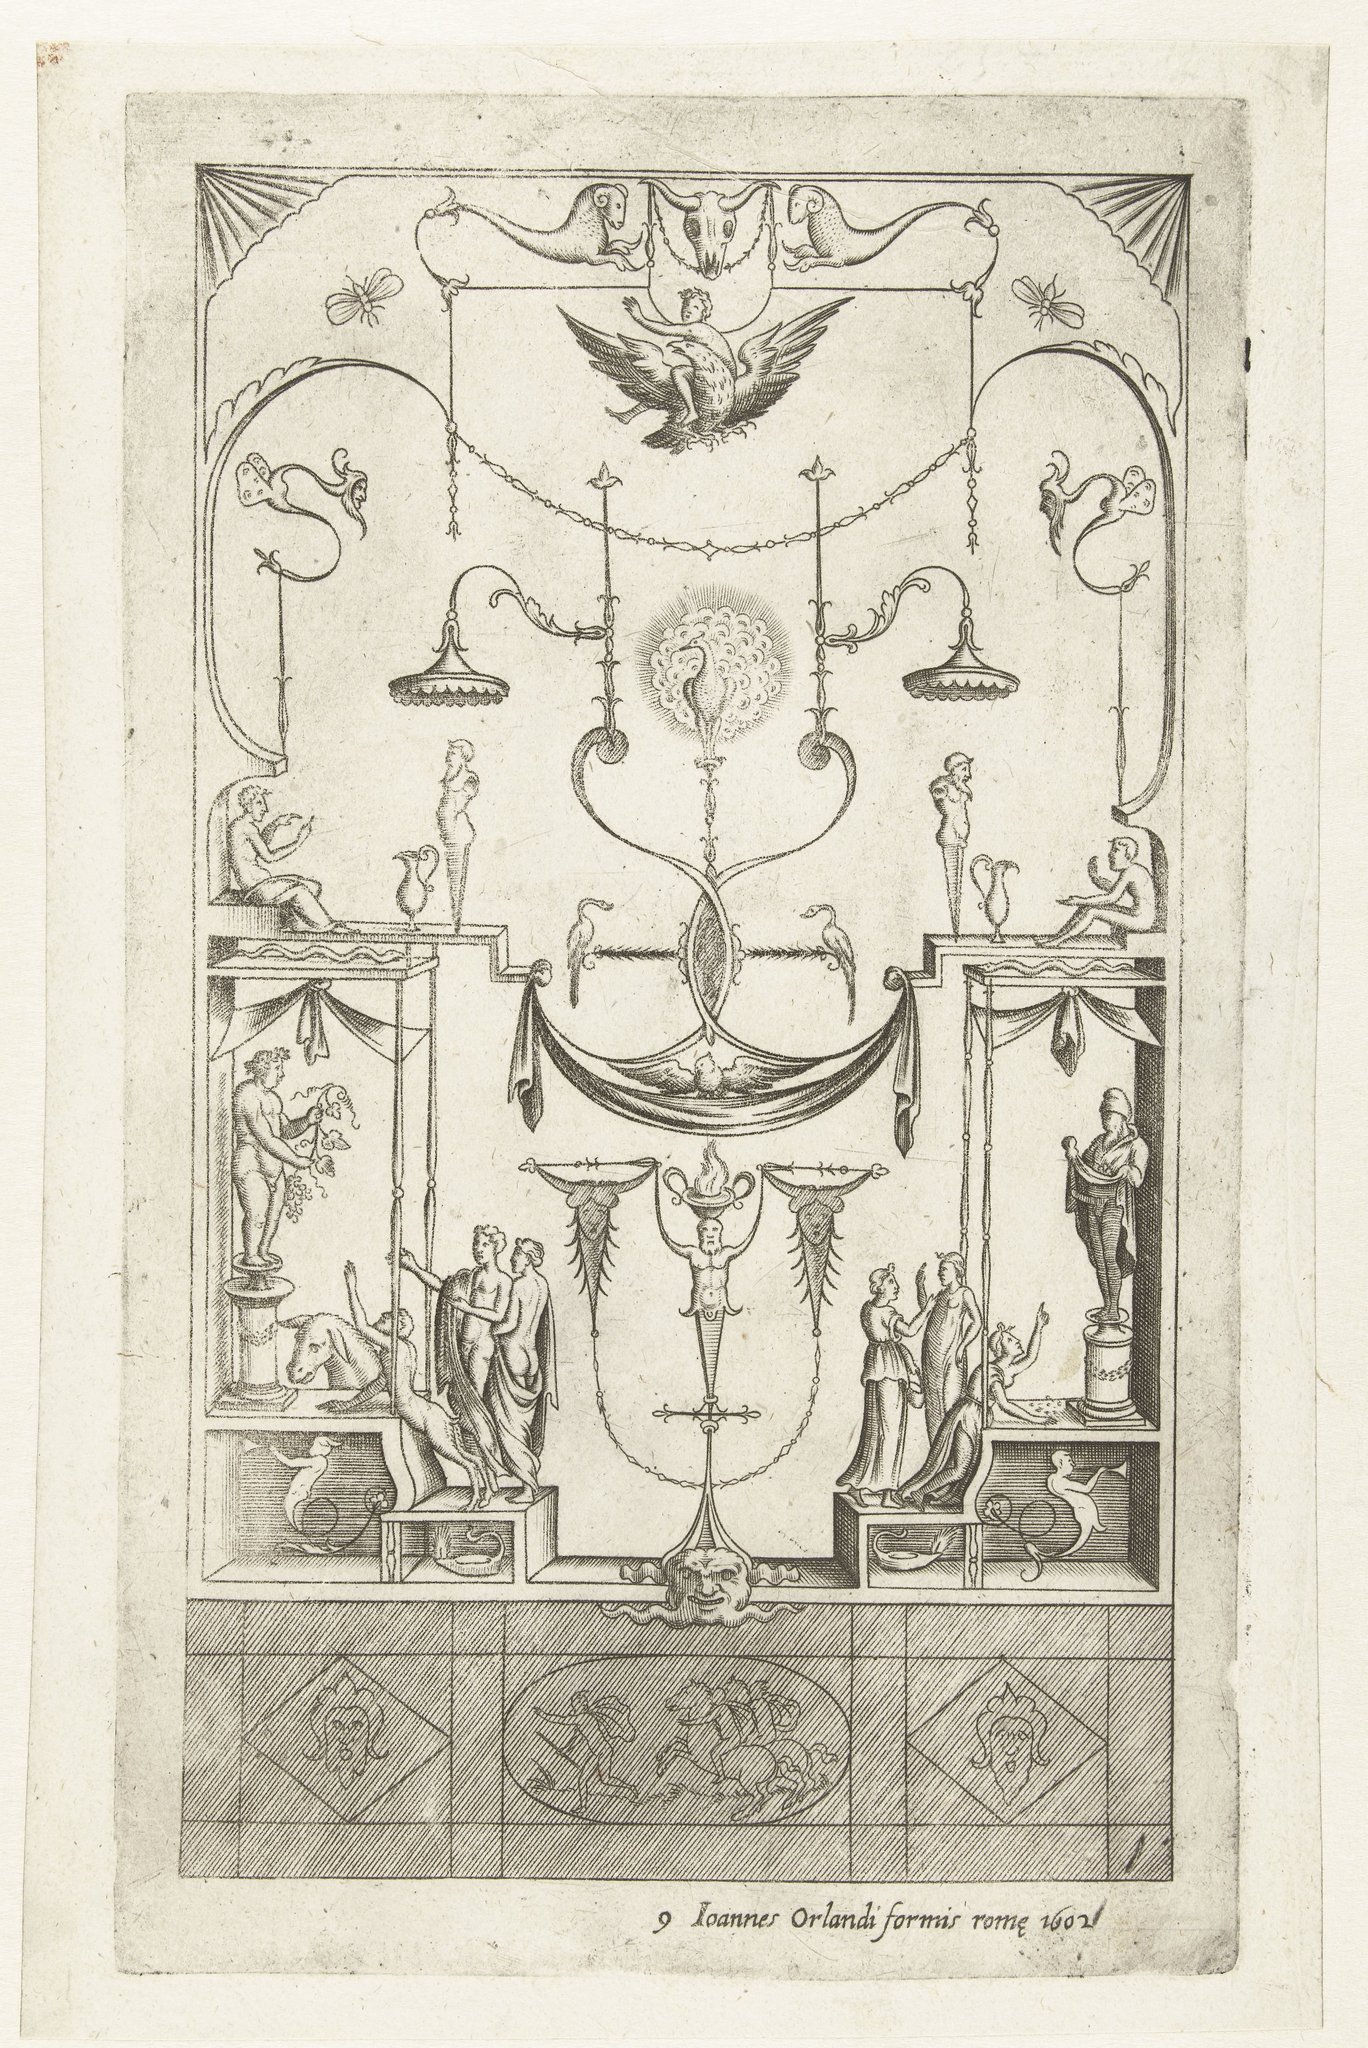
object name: print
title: Leviores et ut videtur extemporaneae picturae quas grotteschas vulgo vocant (...)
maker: Anonymous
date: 1530-1540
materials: paper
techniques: engraving, etching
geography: italy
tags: the rape of ganymede: he is carried off through the air by jupiter in the form of an eagle, or by the eagle of jupiter, ornament derived from architectural details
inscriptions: signature and date: ‘rechtsonder: "Ioannes Orlandi formis rome 1602"’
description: Links Bacchus en rechts Priapus onder een baldakijn op een ronde sokkel, aanbeden door verschillende figuren. In het bovenste gedeelte saters en hermen. Uit serie van 20 bladen.